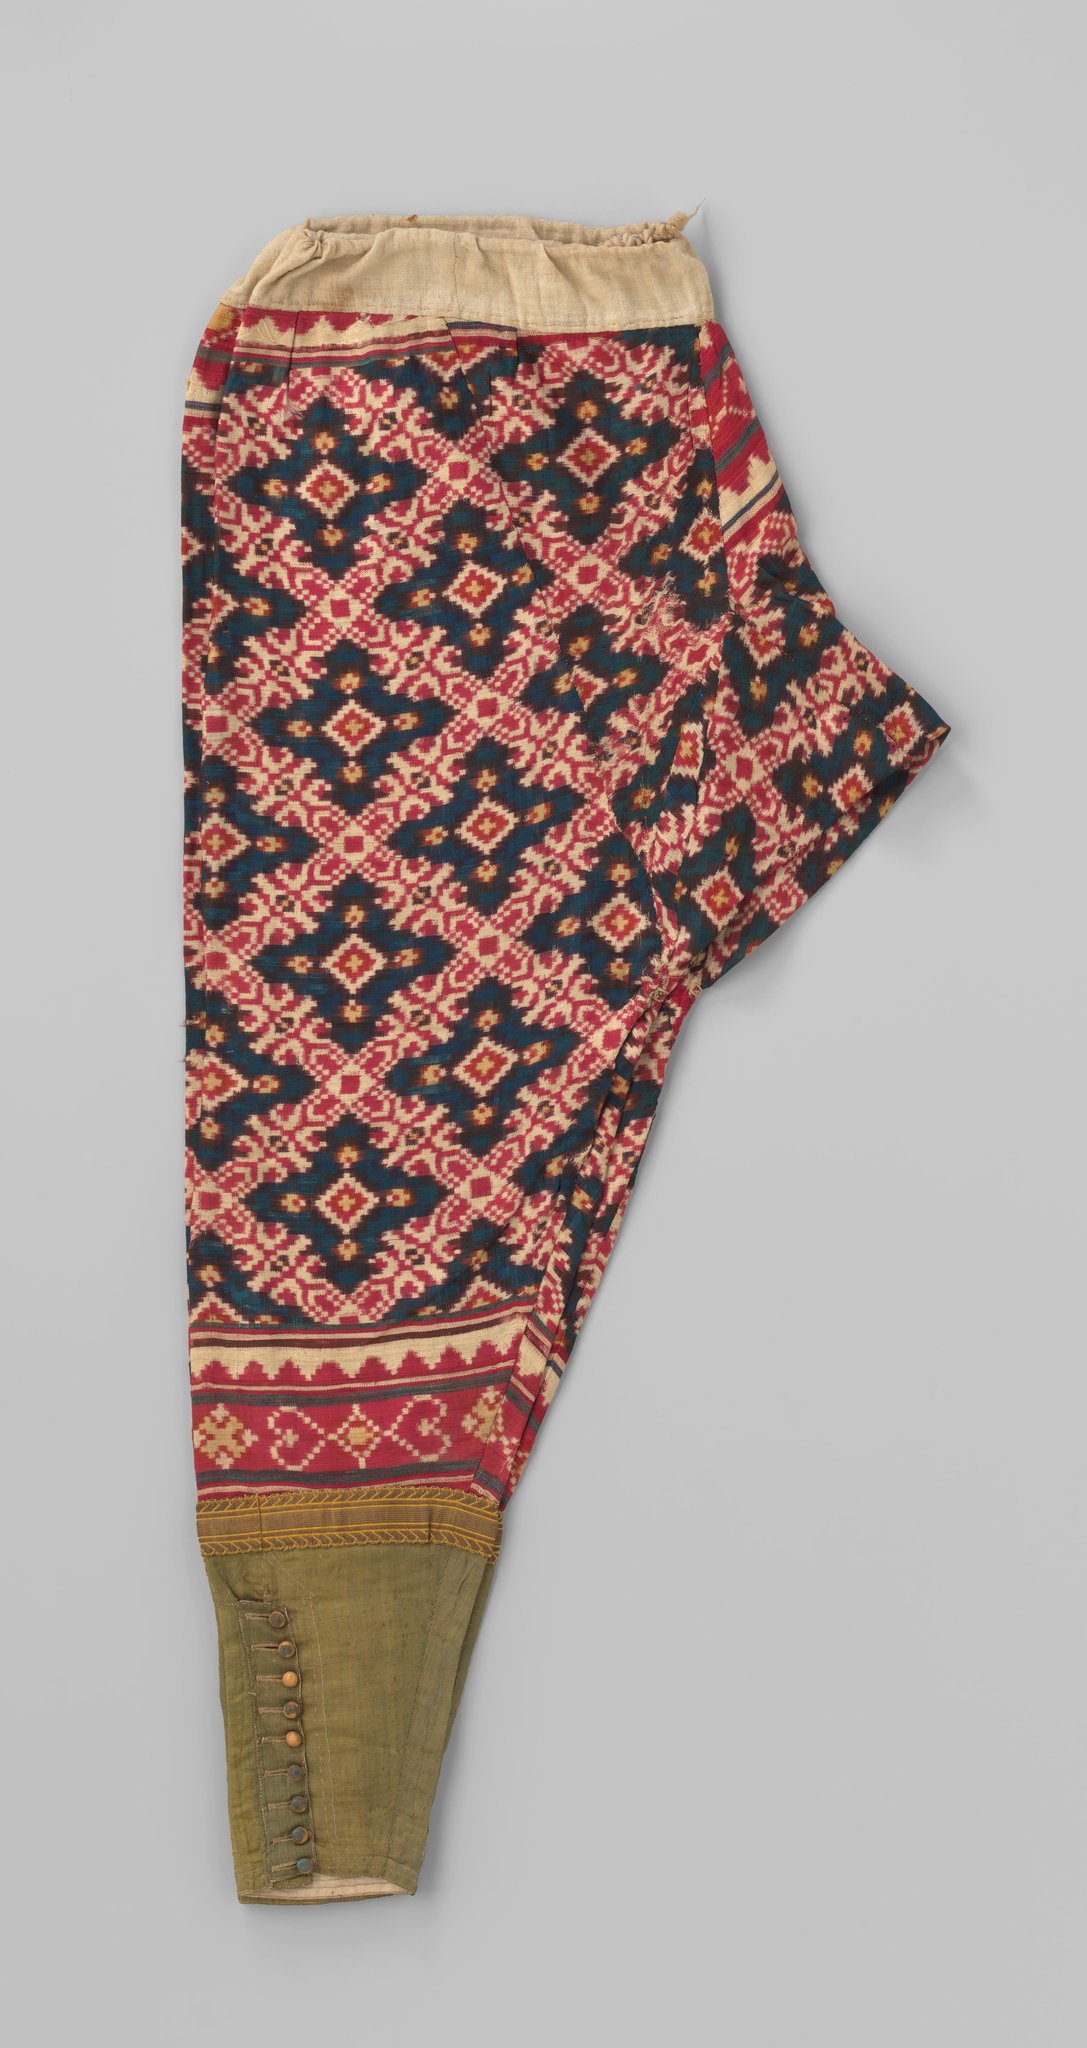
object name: pant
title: Broek van ikat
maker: Anonymous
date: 1850-1950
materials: metal, silk, textile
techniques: ikat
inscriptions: label: ‘N. SIX’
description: De broek sluit met een koord. Aan weerszijden van de effen olijfgroene pijpen van zijde zitten 9 goudkleurige turkoois gepatineerde bolle knopen.